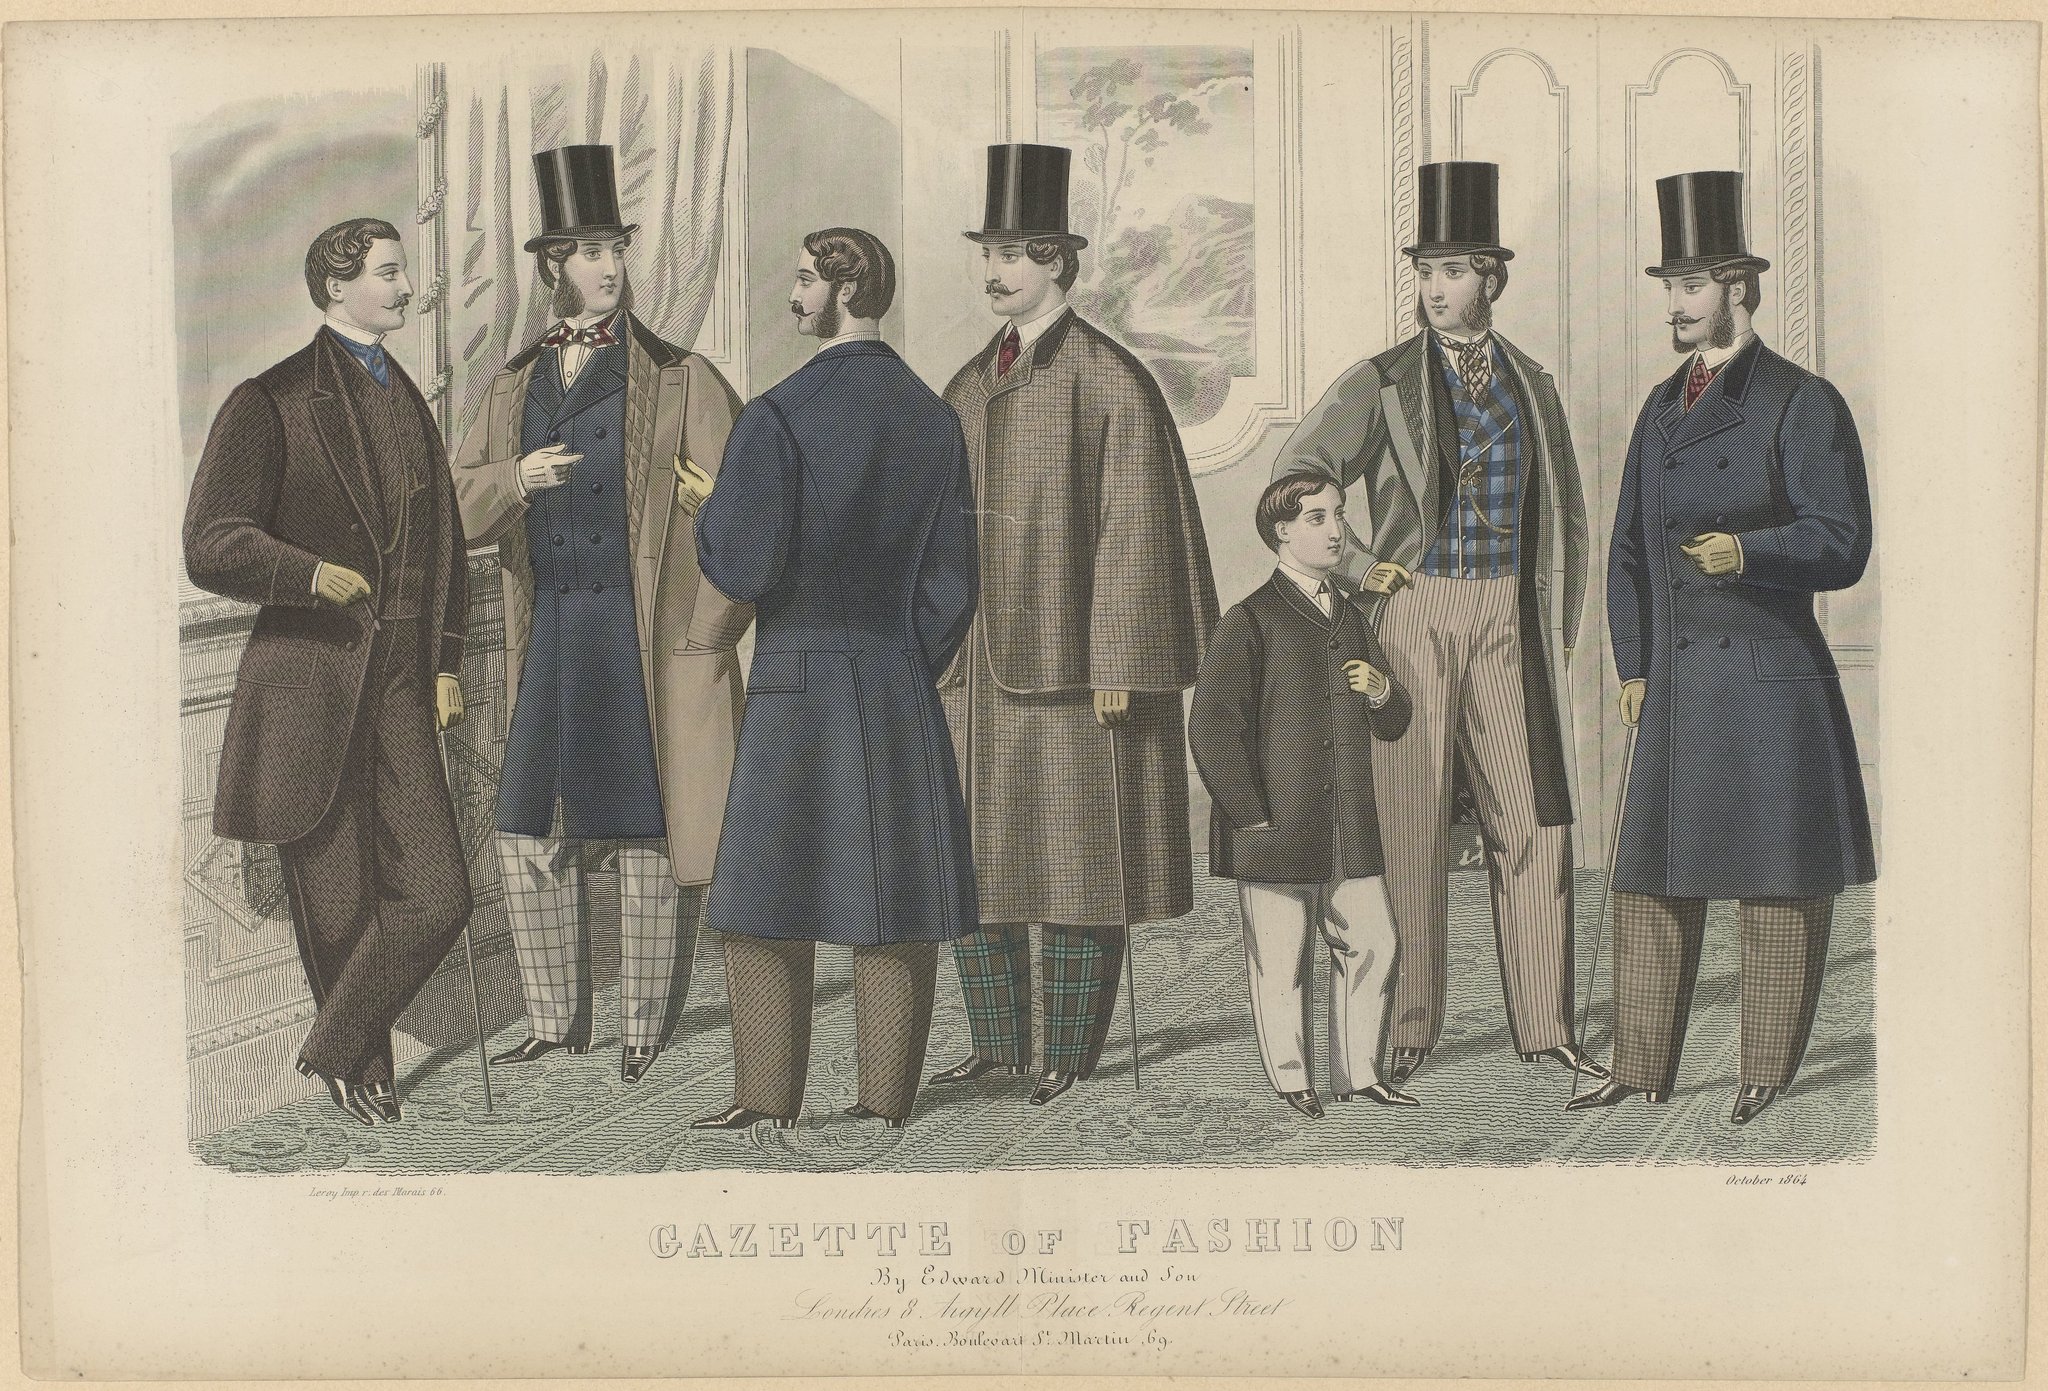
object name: fashion print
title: Gazette of Fashion, October 1864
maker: Anonymous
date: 1864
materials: paper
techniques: engraving, hand coloring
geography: london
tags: clothing for the upper part of the body (vest) (+ men's clothes), trousers, breeches (+ boys' clothes), trousers, breeches, etc. (pantalon) (+ men's clothes), coat: overcoat (+ men's clothes), coat (+ men's clothes), coat (+ boys' clothes), fashion plates, walking-stick, staff, cane (+ men's clothes)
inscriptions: title: ‘GAZETTE OF FASHION by Edward Minister and Son’, address: ‘8, Argyll Place Regent Street London. / Paris, boul. S.t Martin, 69’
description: Zes mannen herenkostuums en een jongenskostuum. Overjassen, met en zonder pelerine, sommige doublebreasted. Accessoires: hoge hoed, geruite das, dasspeld, horlogeketting, schoenen met hakken. Prent uit het modetijdschrift The Gazette of Fashion, and Cutting-Room Compagnion (1847-19..?).